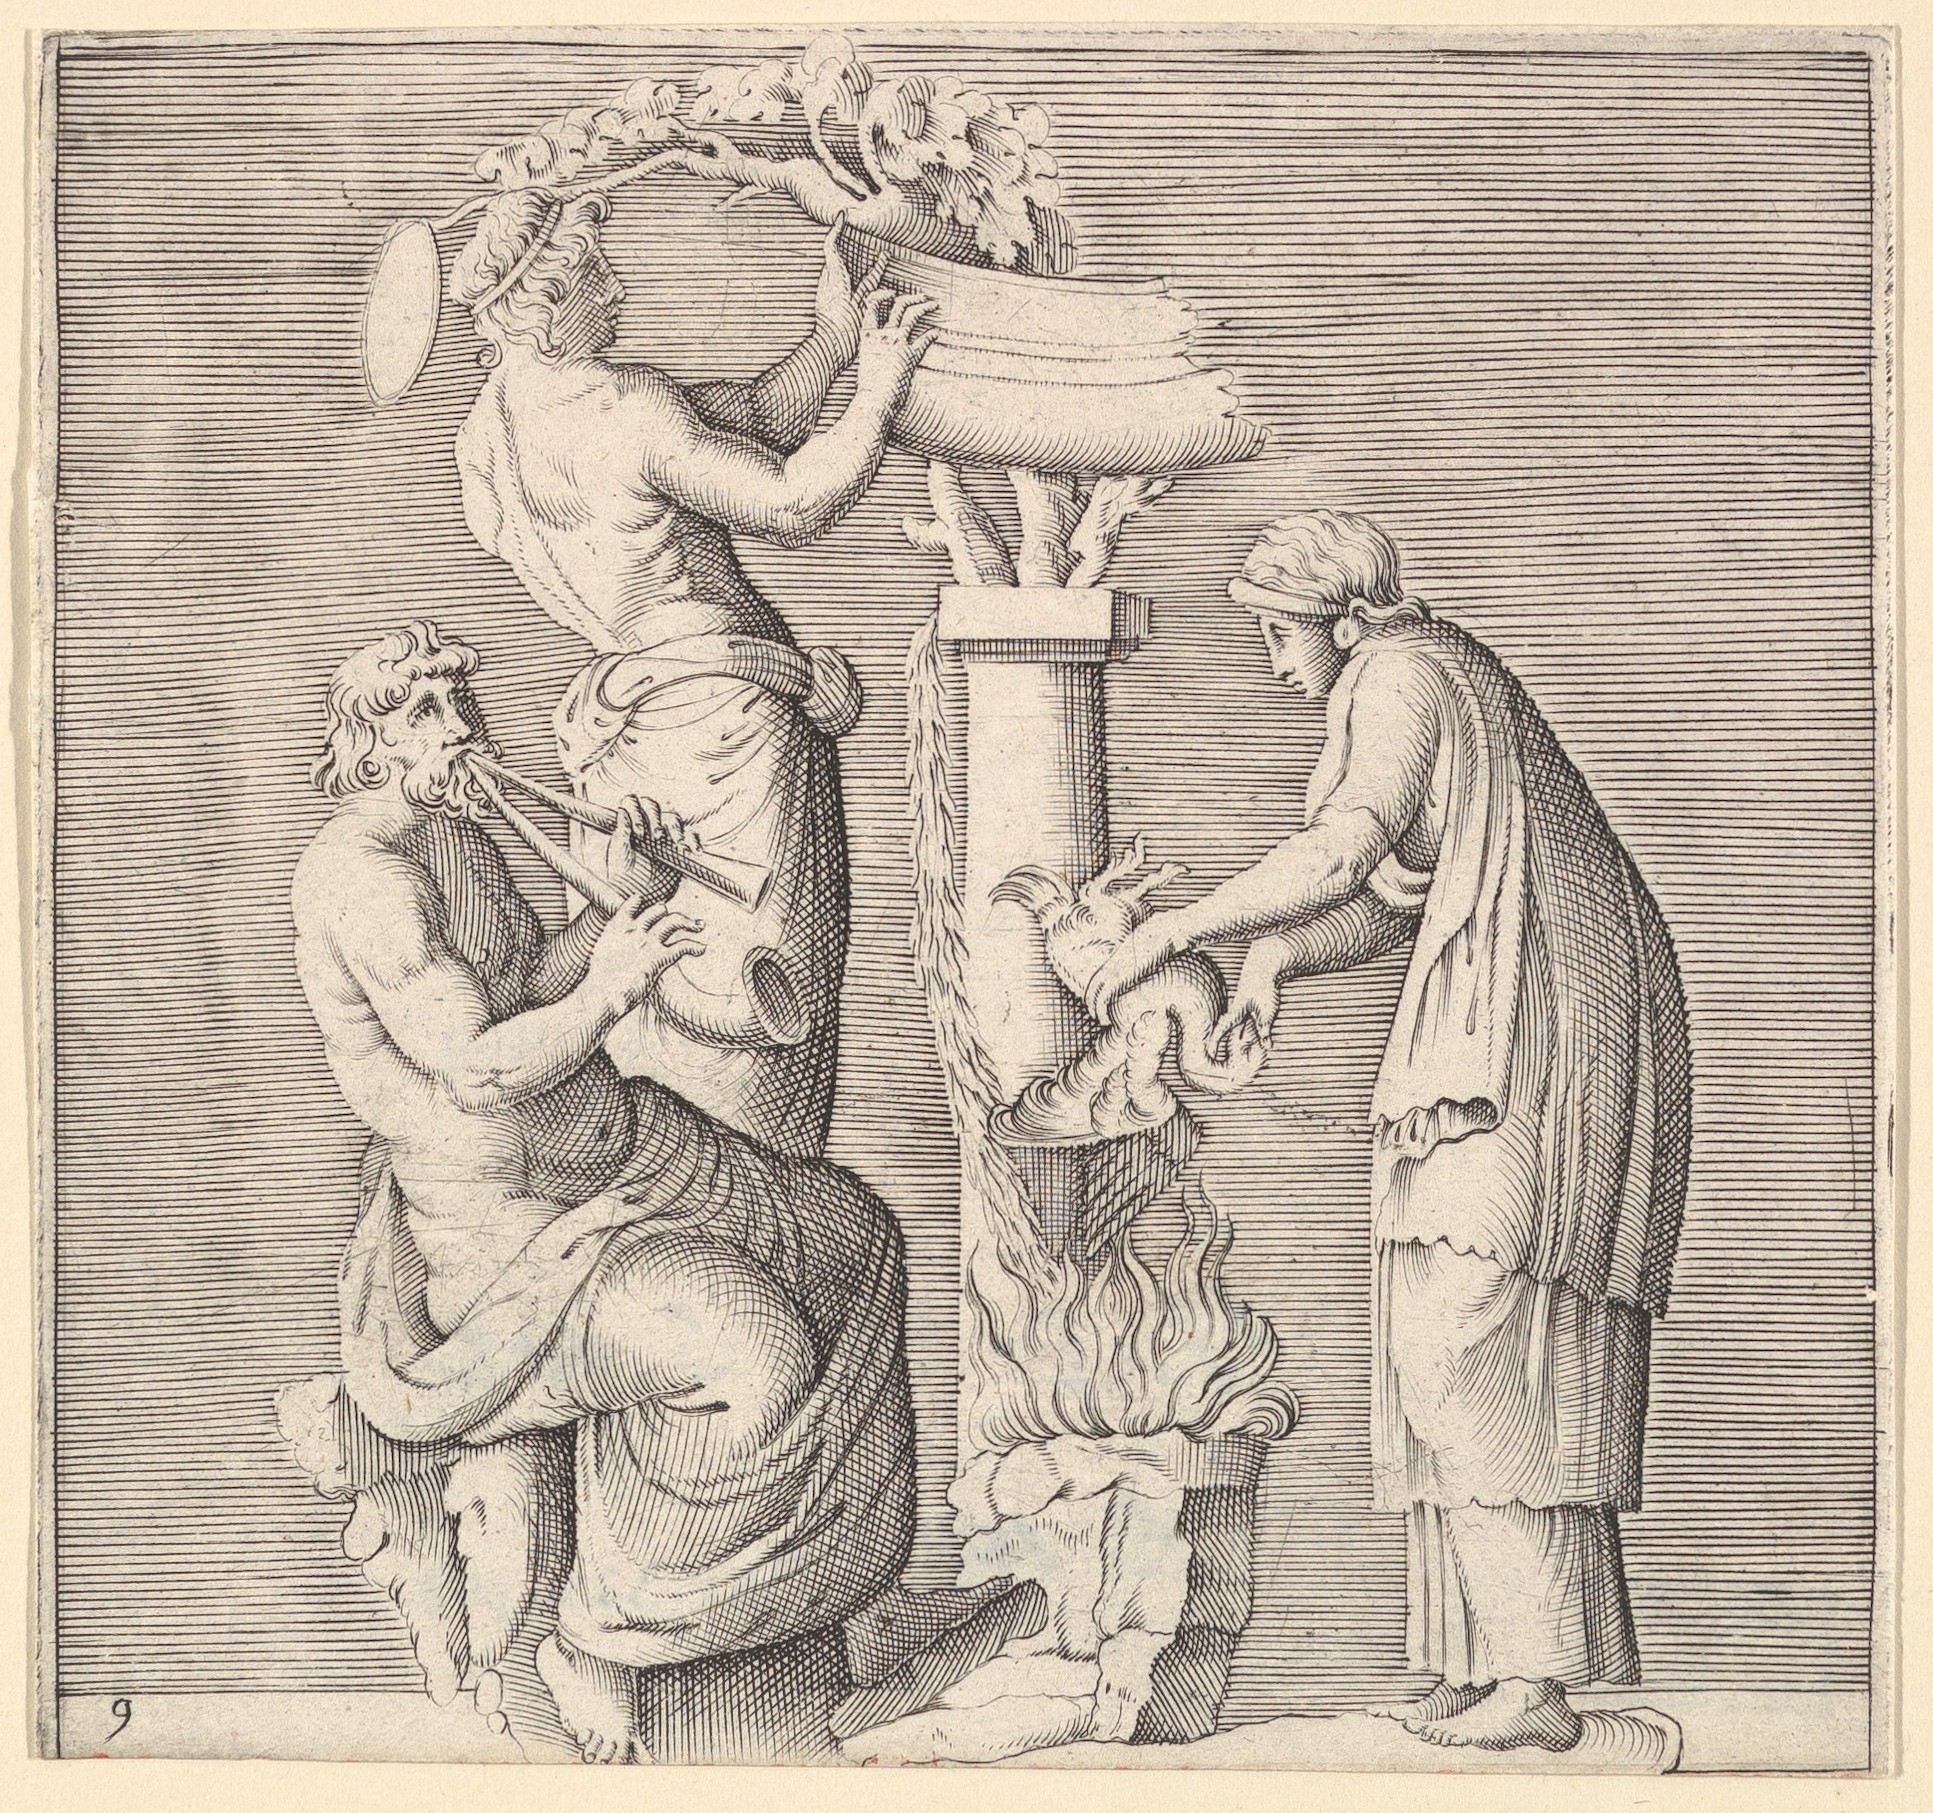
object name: print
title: Sacrifice of a Swan, from "Ex Antiquis Cameorum et Gemmae Delineata/ Liber Secundus/et ab Enea Vico Parmen Incis"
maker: anonymous, italian, 16th century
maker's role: artist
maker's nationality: italian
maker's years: 1500-1600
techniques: engraving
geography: rome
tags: men,women,horns,swans